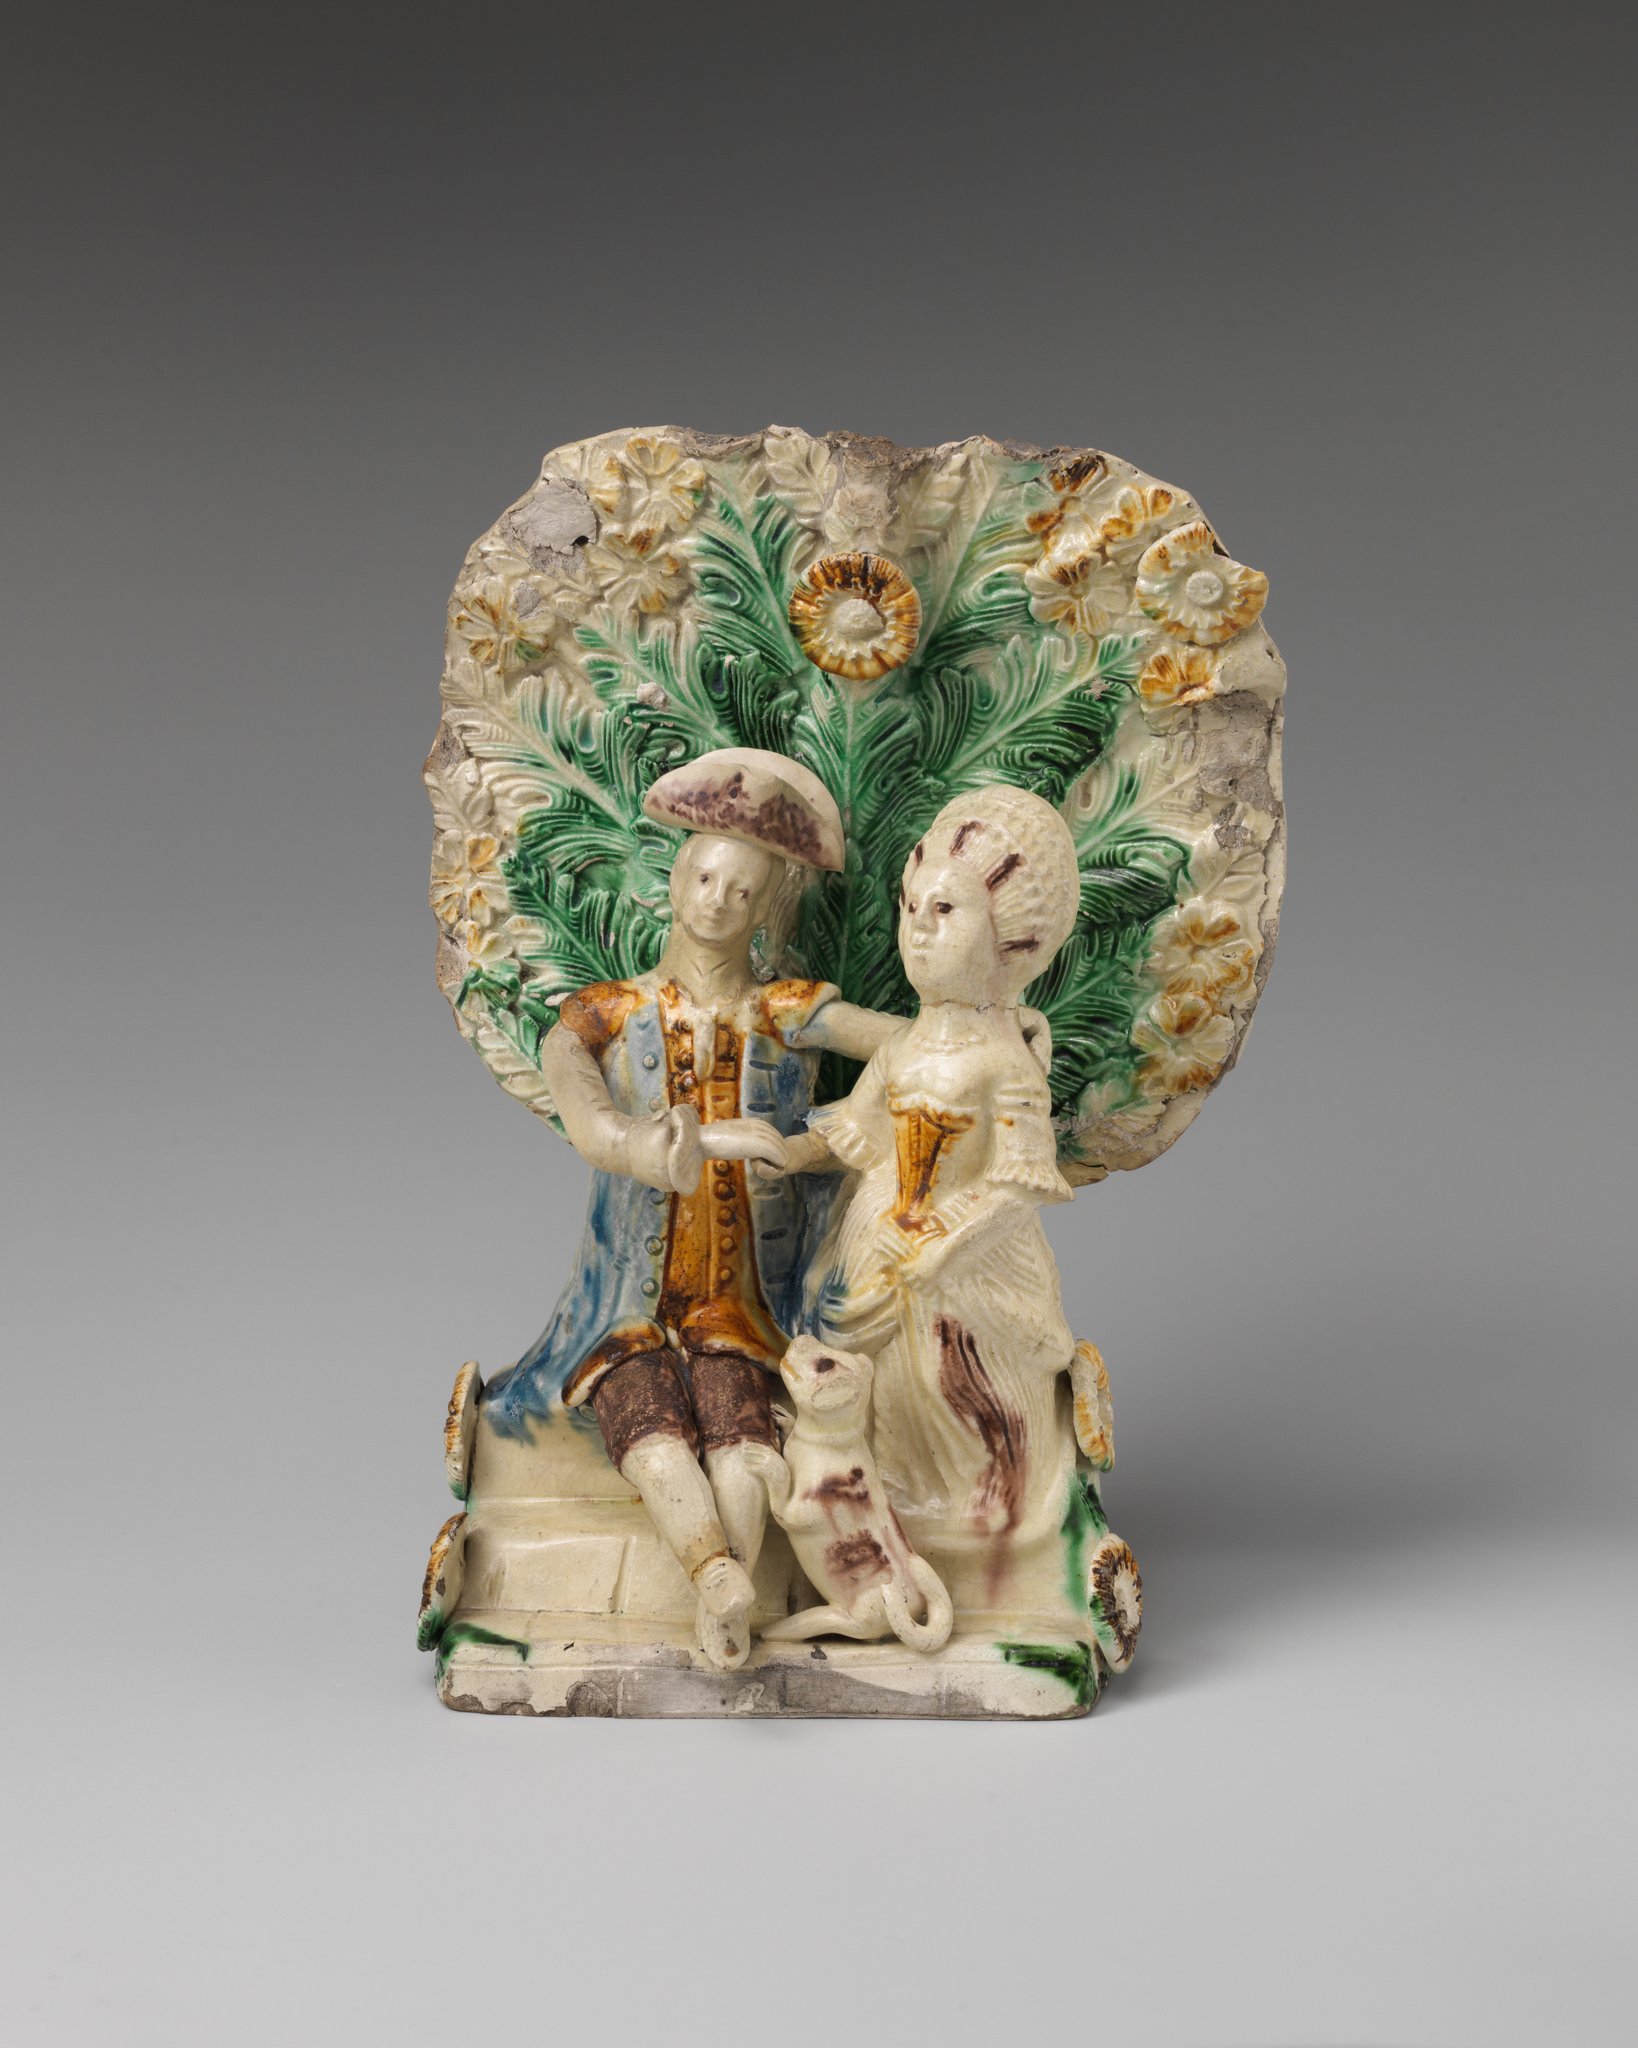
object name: figure group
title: Arbor group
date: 1750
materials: earthenware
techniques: glazing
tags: couples,men,women,dogs